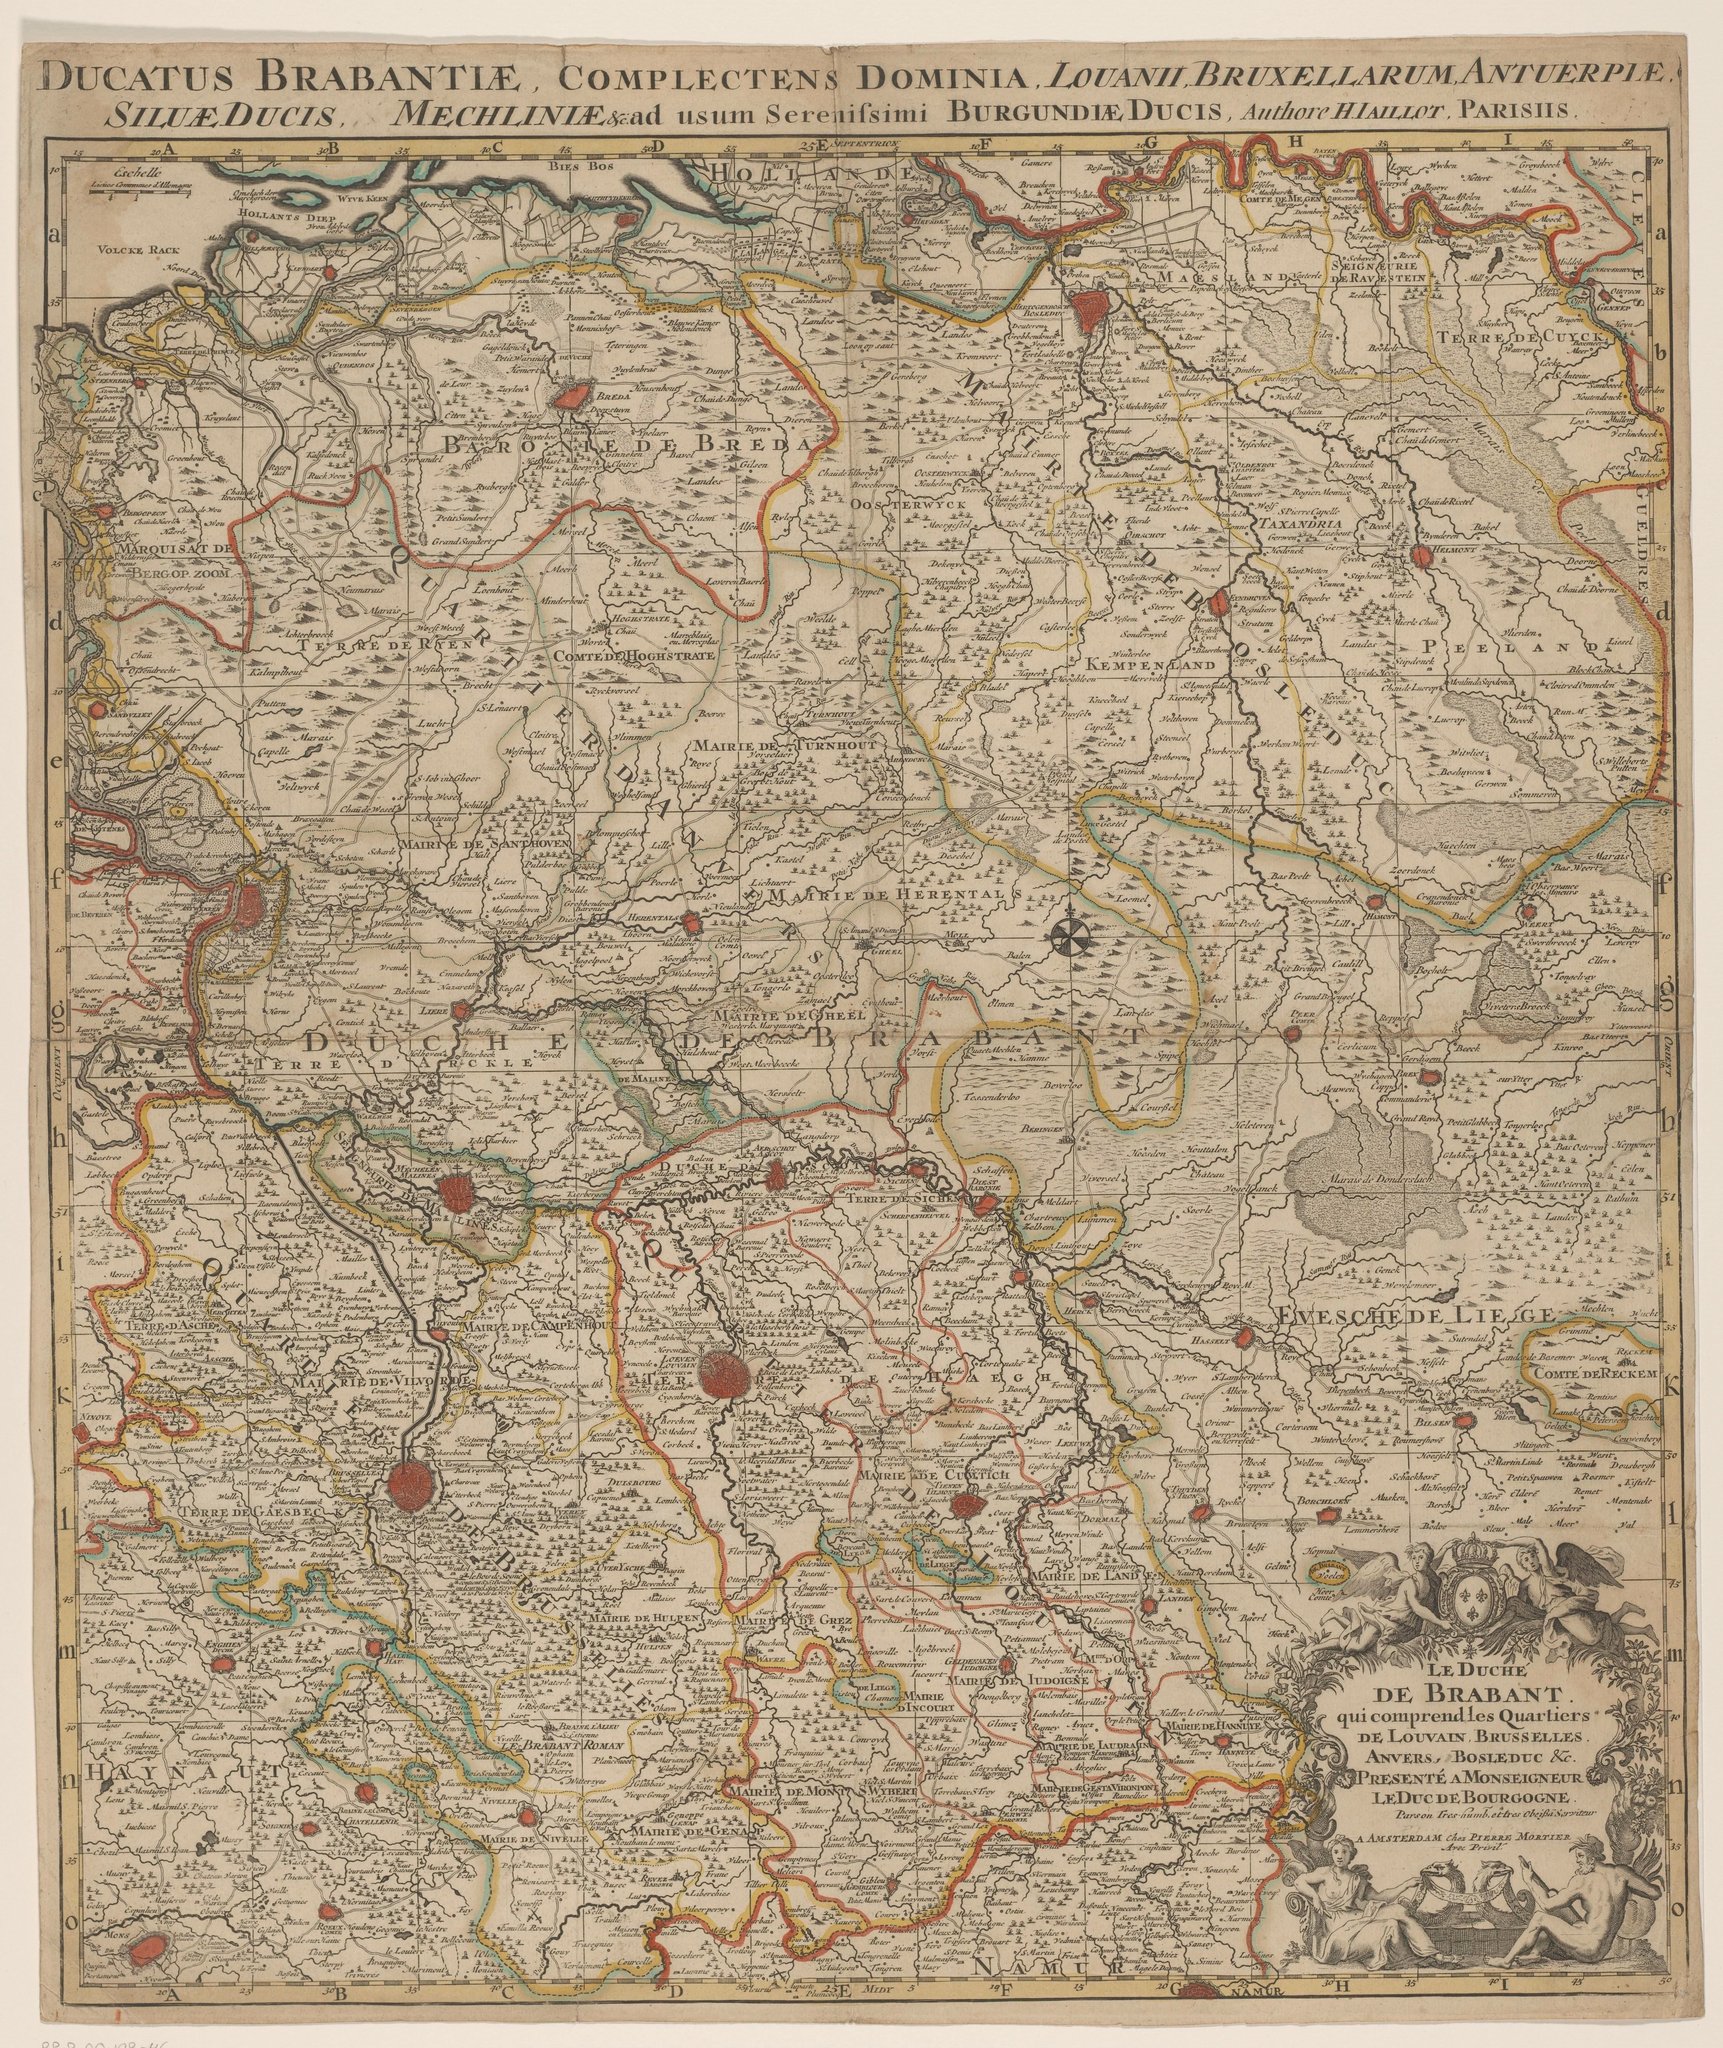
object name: print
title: Ducatus Brabantiae, complectens dominia, Louanii, Bruxellarum (...) / Le duché de Brabant qui comprend les quartiers de Louvain, Brusselles (...)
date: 1690-1711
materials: paper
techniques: engraving, etching, hand coloring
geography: amsterdam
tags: maps of separate countries or regions, coat of arms (as symbol of the state, etc.) (+ province; provincial), brabant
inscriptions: collector's mark: Lugt 2228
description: Kaart van het hertogdom Brabant. Boven de kaart de titel. Rechtsonder een cartouche met opdracht en tweede titel, bovenin het wapen van het Koninkrijk Frankrijk. Linksboven een schaalstok: 1 Lieües Communes d'Allemagne. De kaart is voorzien van een zoekrooster en een gradenverdeling langs de randen.